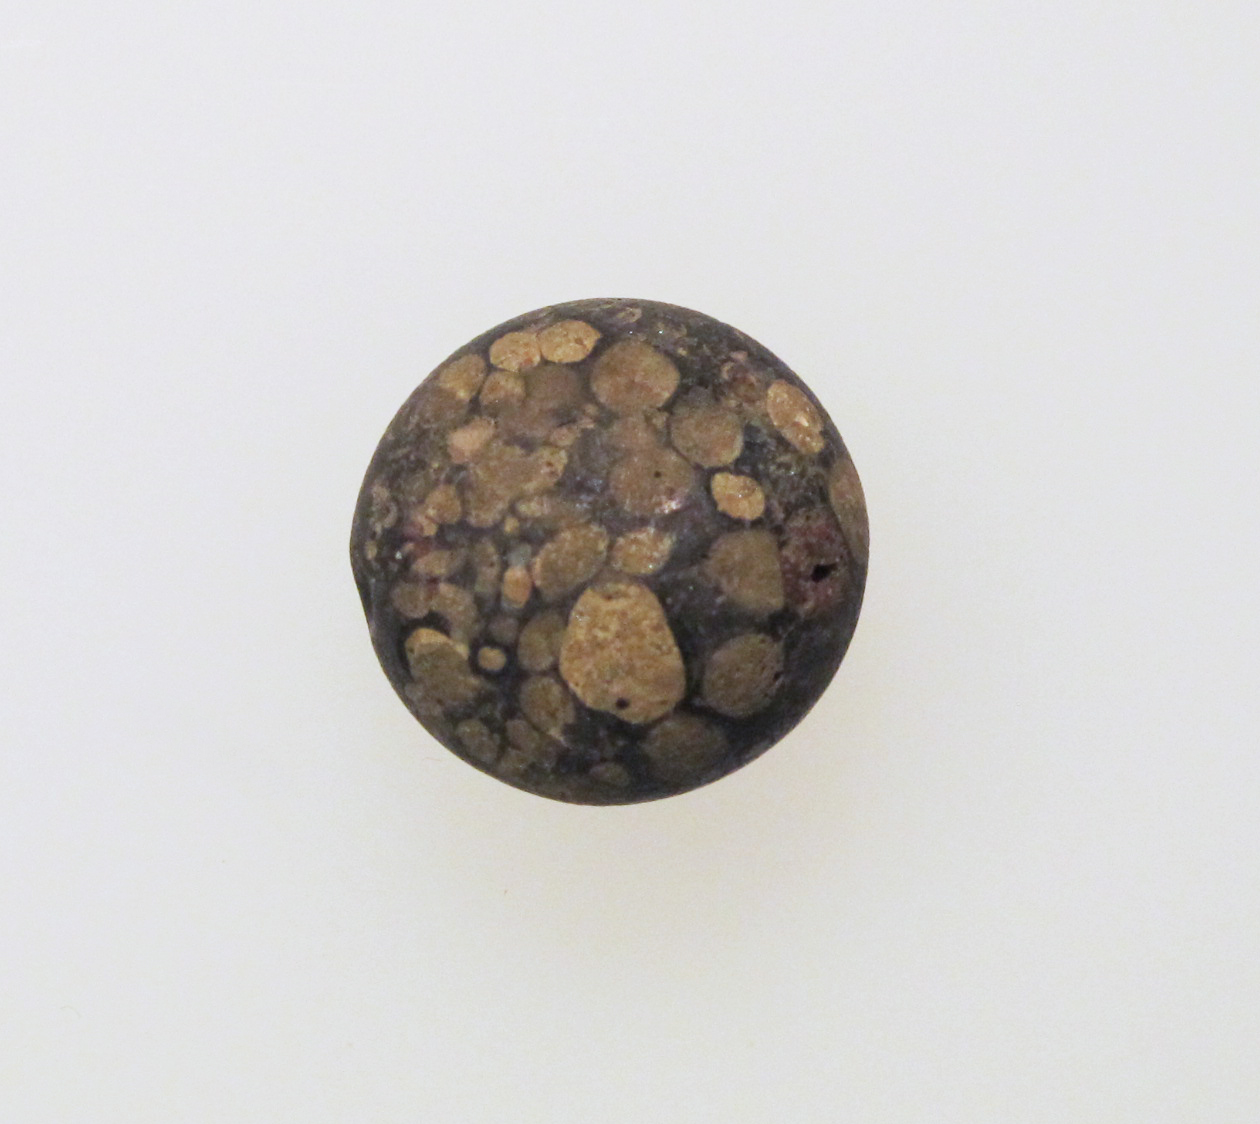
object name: pinhead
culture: roman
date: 670 BCE-330 CE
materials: glass